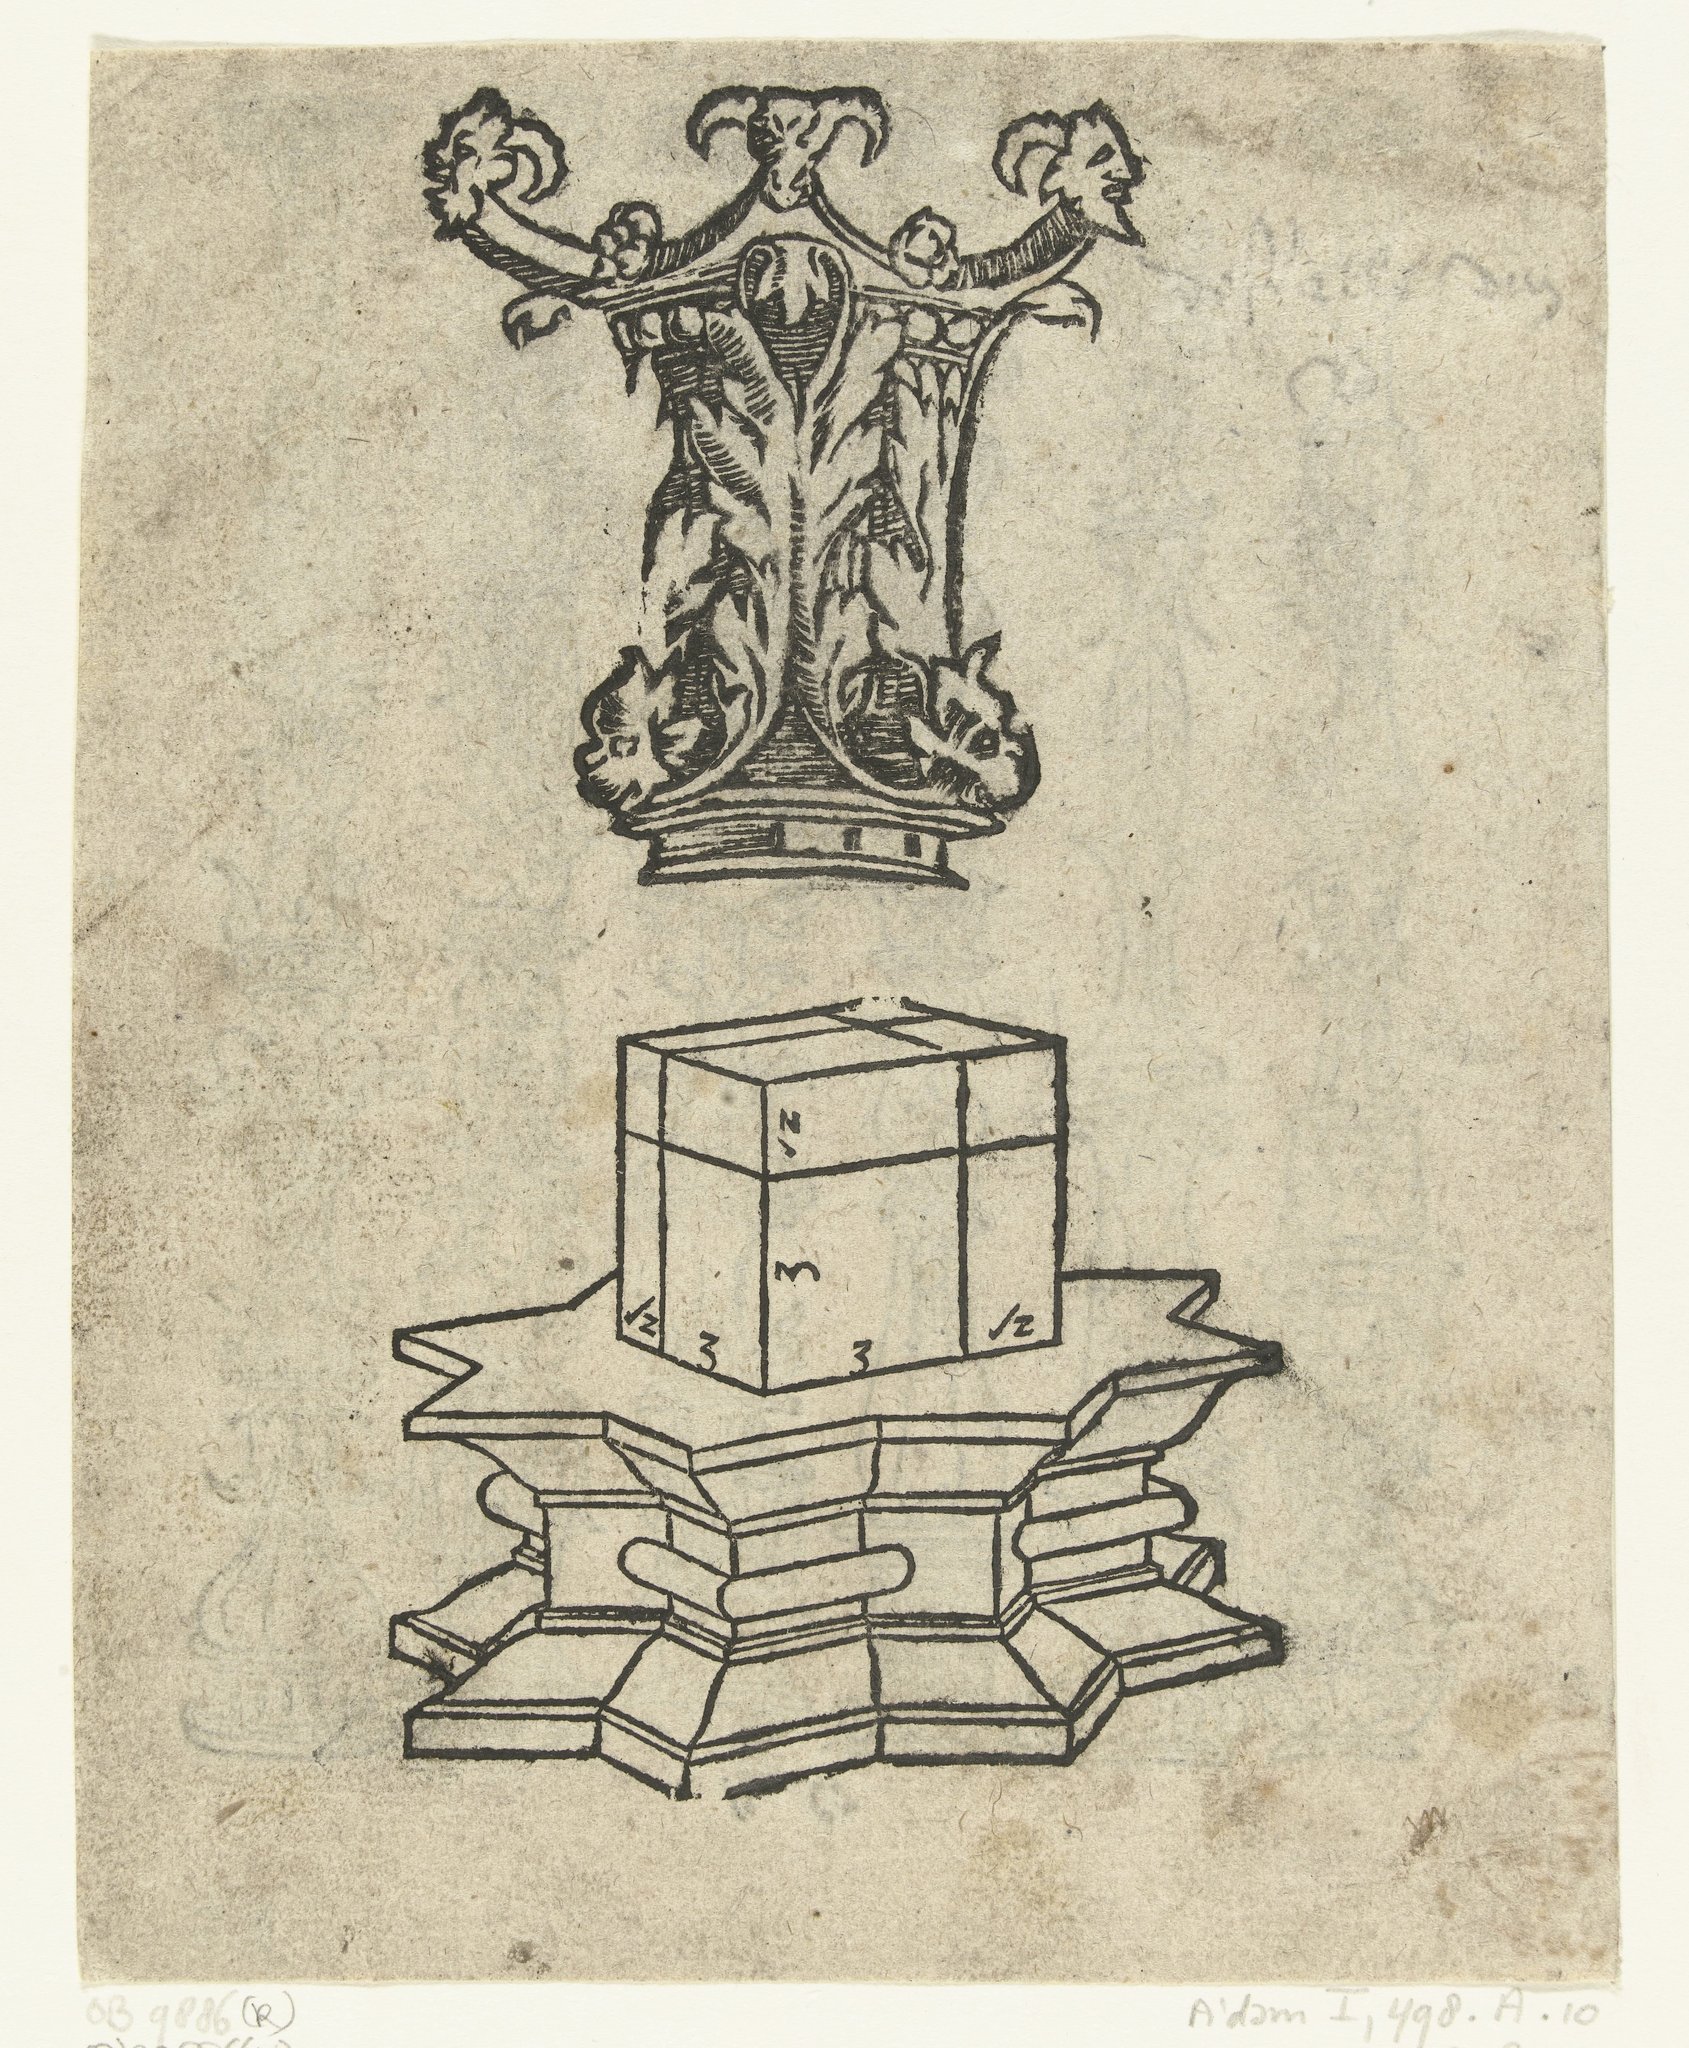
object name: ornament print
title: Latere editie van Ein frembds und wunderbares kunstbüchlin (...)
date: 1500-1568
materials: paper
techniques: woodcut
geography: germany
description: Onderaan de schematische opbouw van een basement. Daarboven een kopie naar het kapiteel met de ramskop en de twee mascarons uit een eerdere editie van deze serie (uitgegeven in 1538). Blad uit serie van 56 (?) bladen.